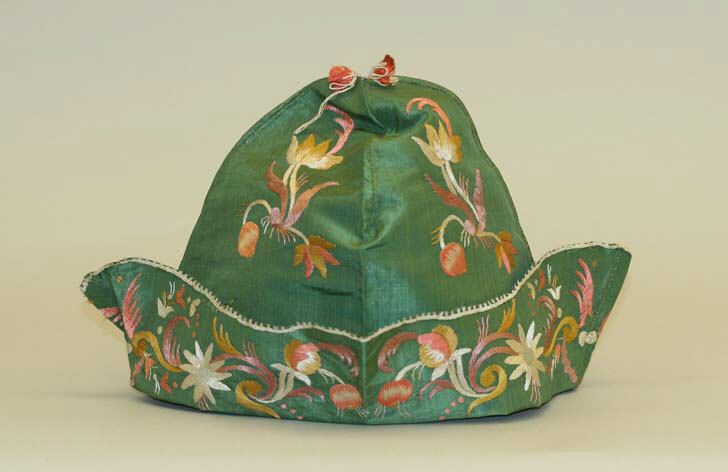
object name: cap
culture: german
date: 1700-1750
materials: silk